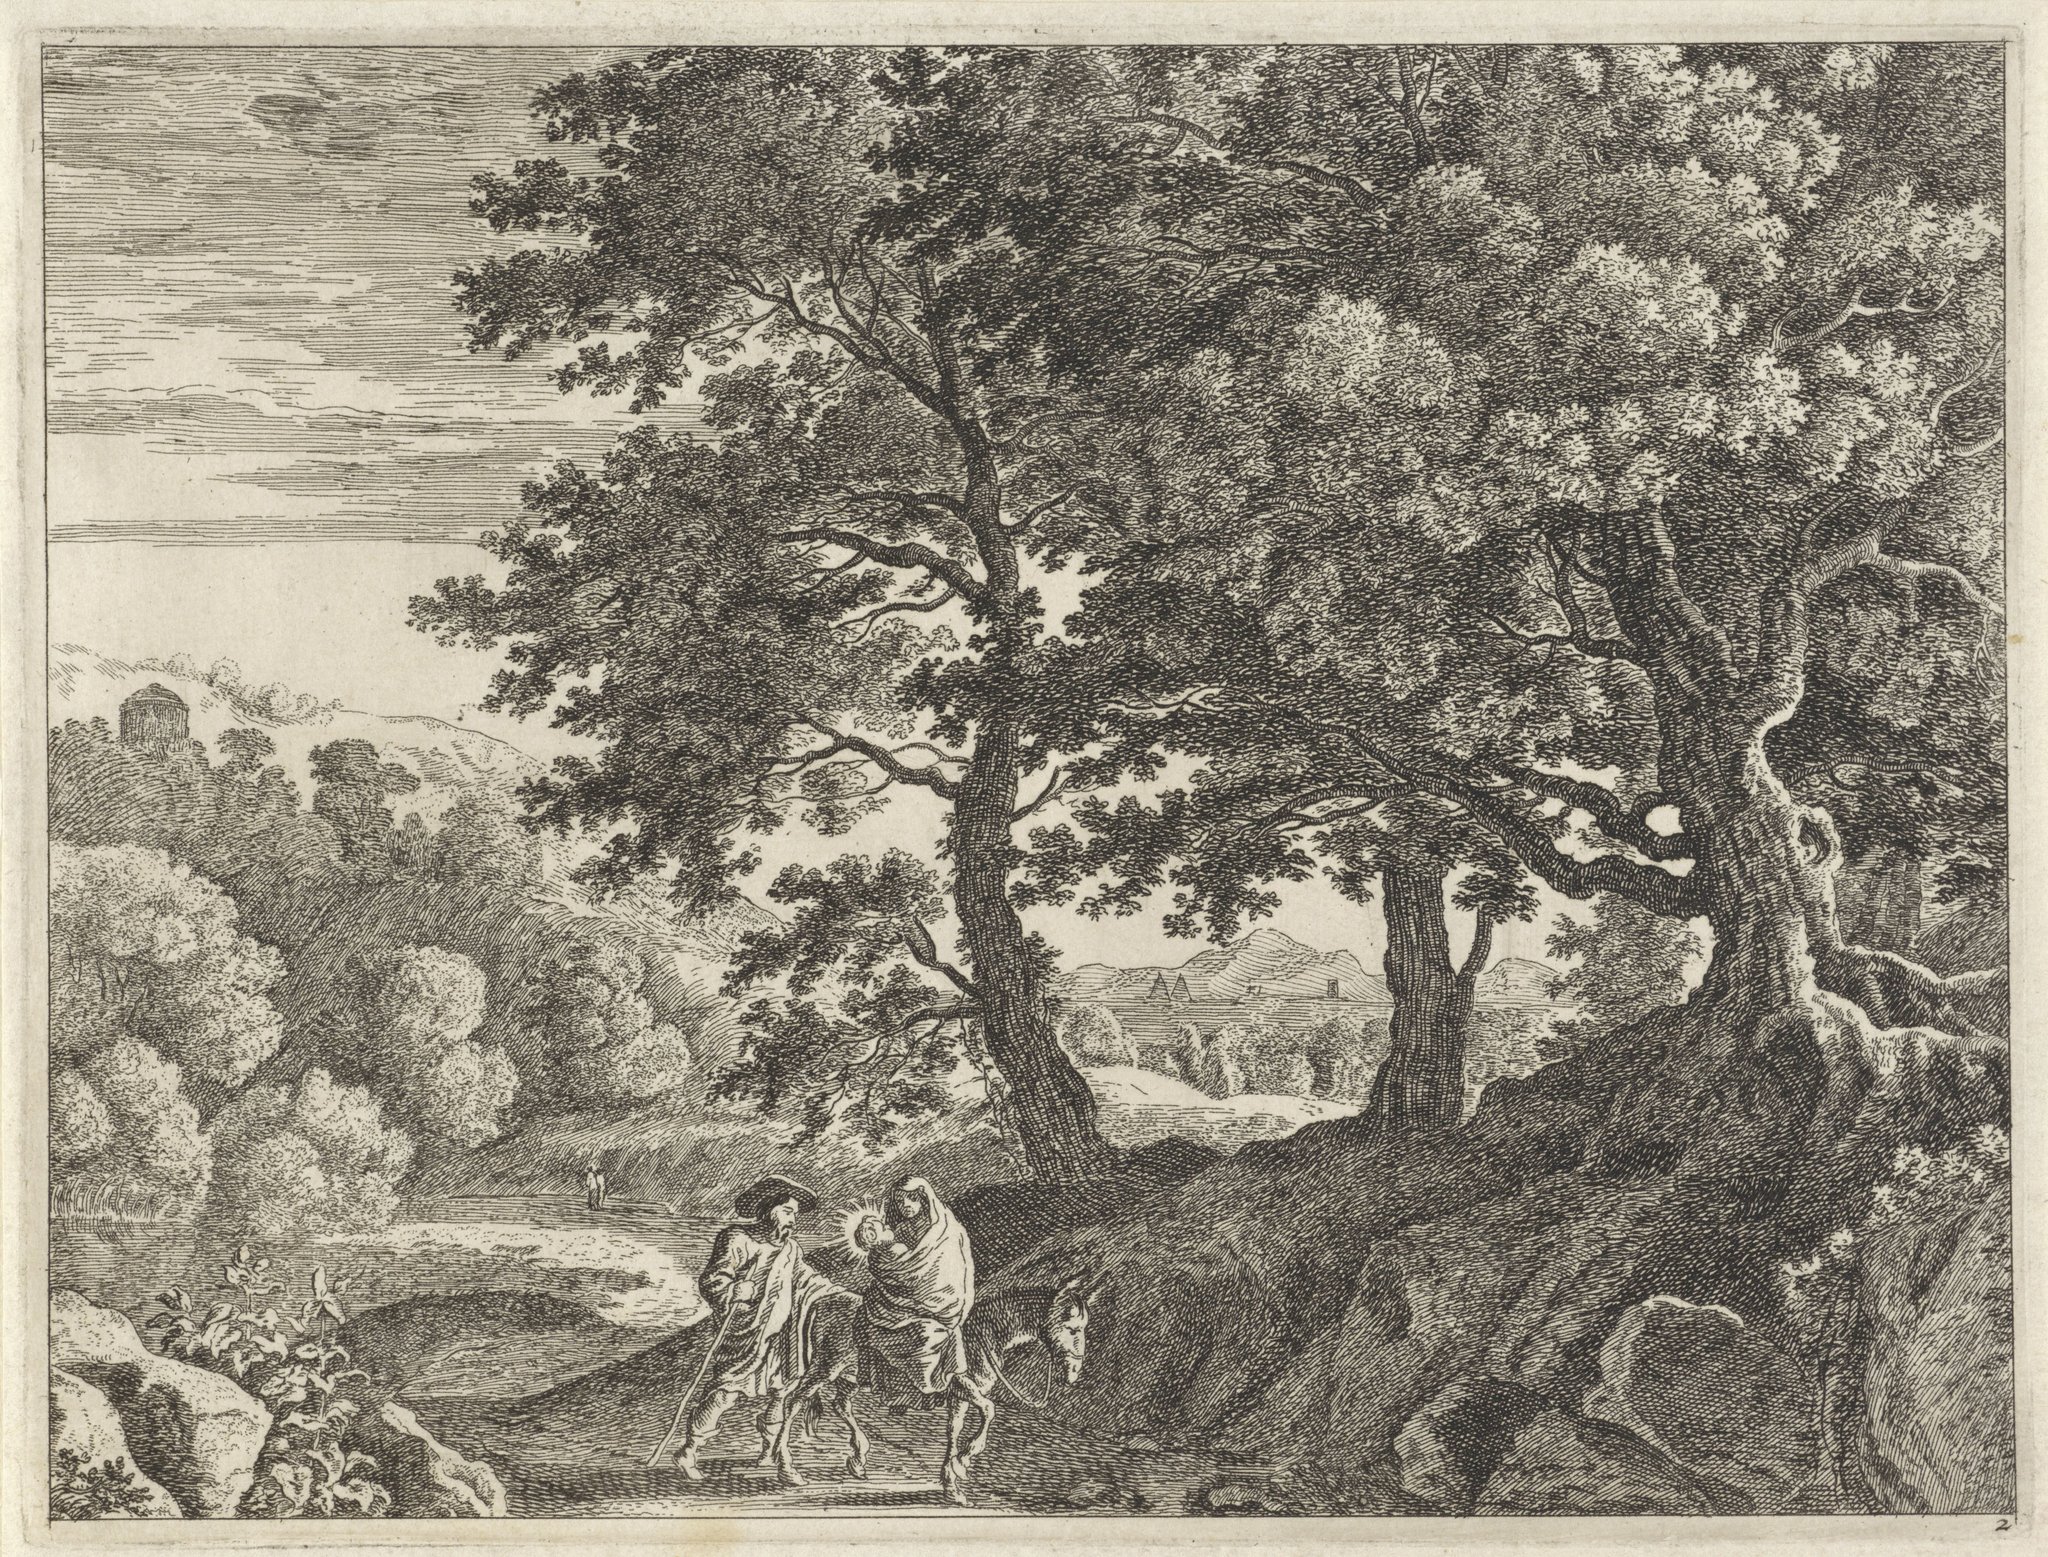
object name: print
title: Verscheyde aerdige lantschappen (...)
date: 1633-1679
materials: paper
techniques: etching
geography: amsterdam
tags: the flight into egypt: mary, joseph, the child (and sometimes others) on their way; mary usually riding on an ass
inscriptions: collector's mark: Lugt 240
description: Maria zit op een ezel met Christus in haar armen. Jozef loopt achter de ezel.